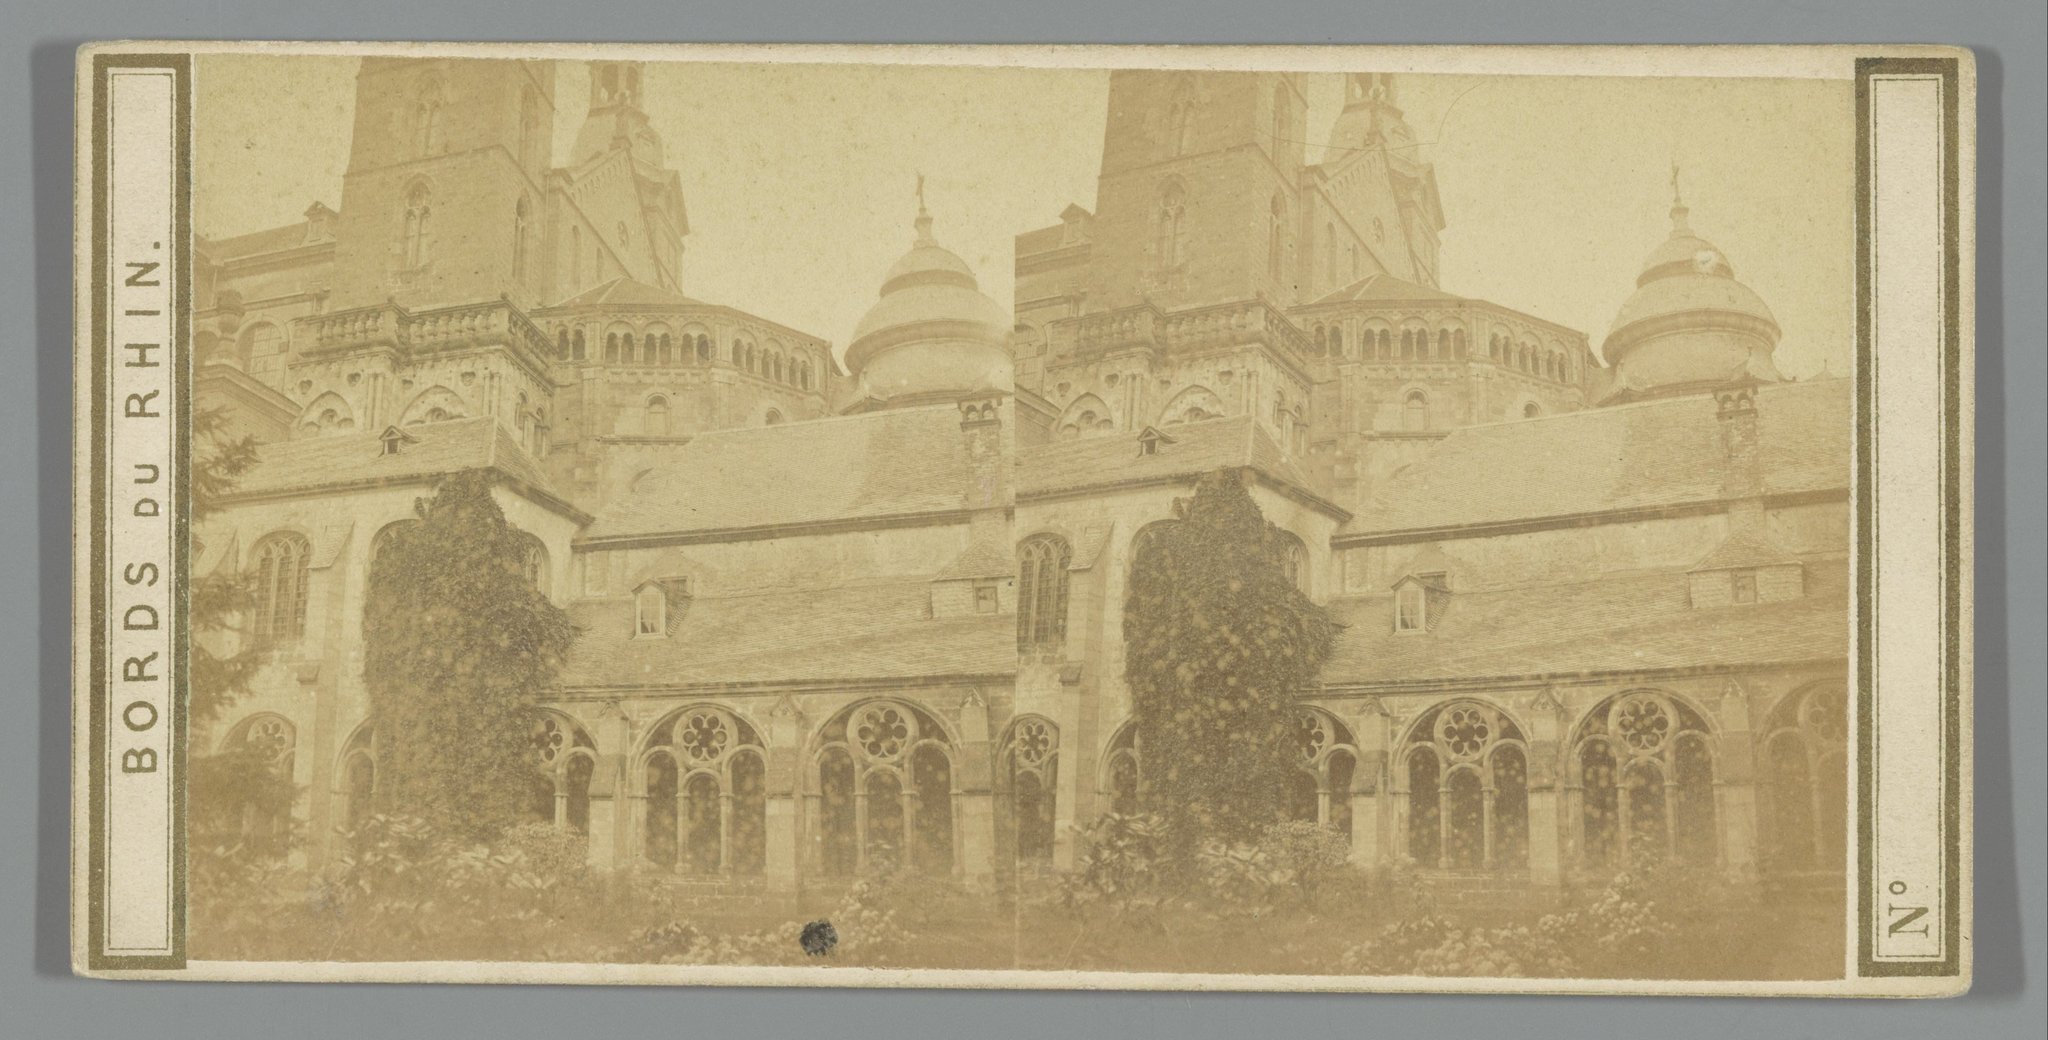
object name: stereograph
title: Bords du Rhin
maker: alexandre bertrand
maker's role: fotograaf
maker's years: 1822-1889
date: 1865-1870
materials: cardboard, photographic support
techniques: albumen print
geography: trier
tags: church (exterior)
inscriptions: number: ‘No 17’, number: ‘No 45’, number: ‘134’